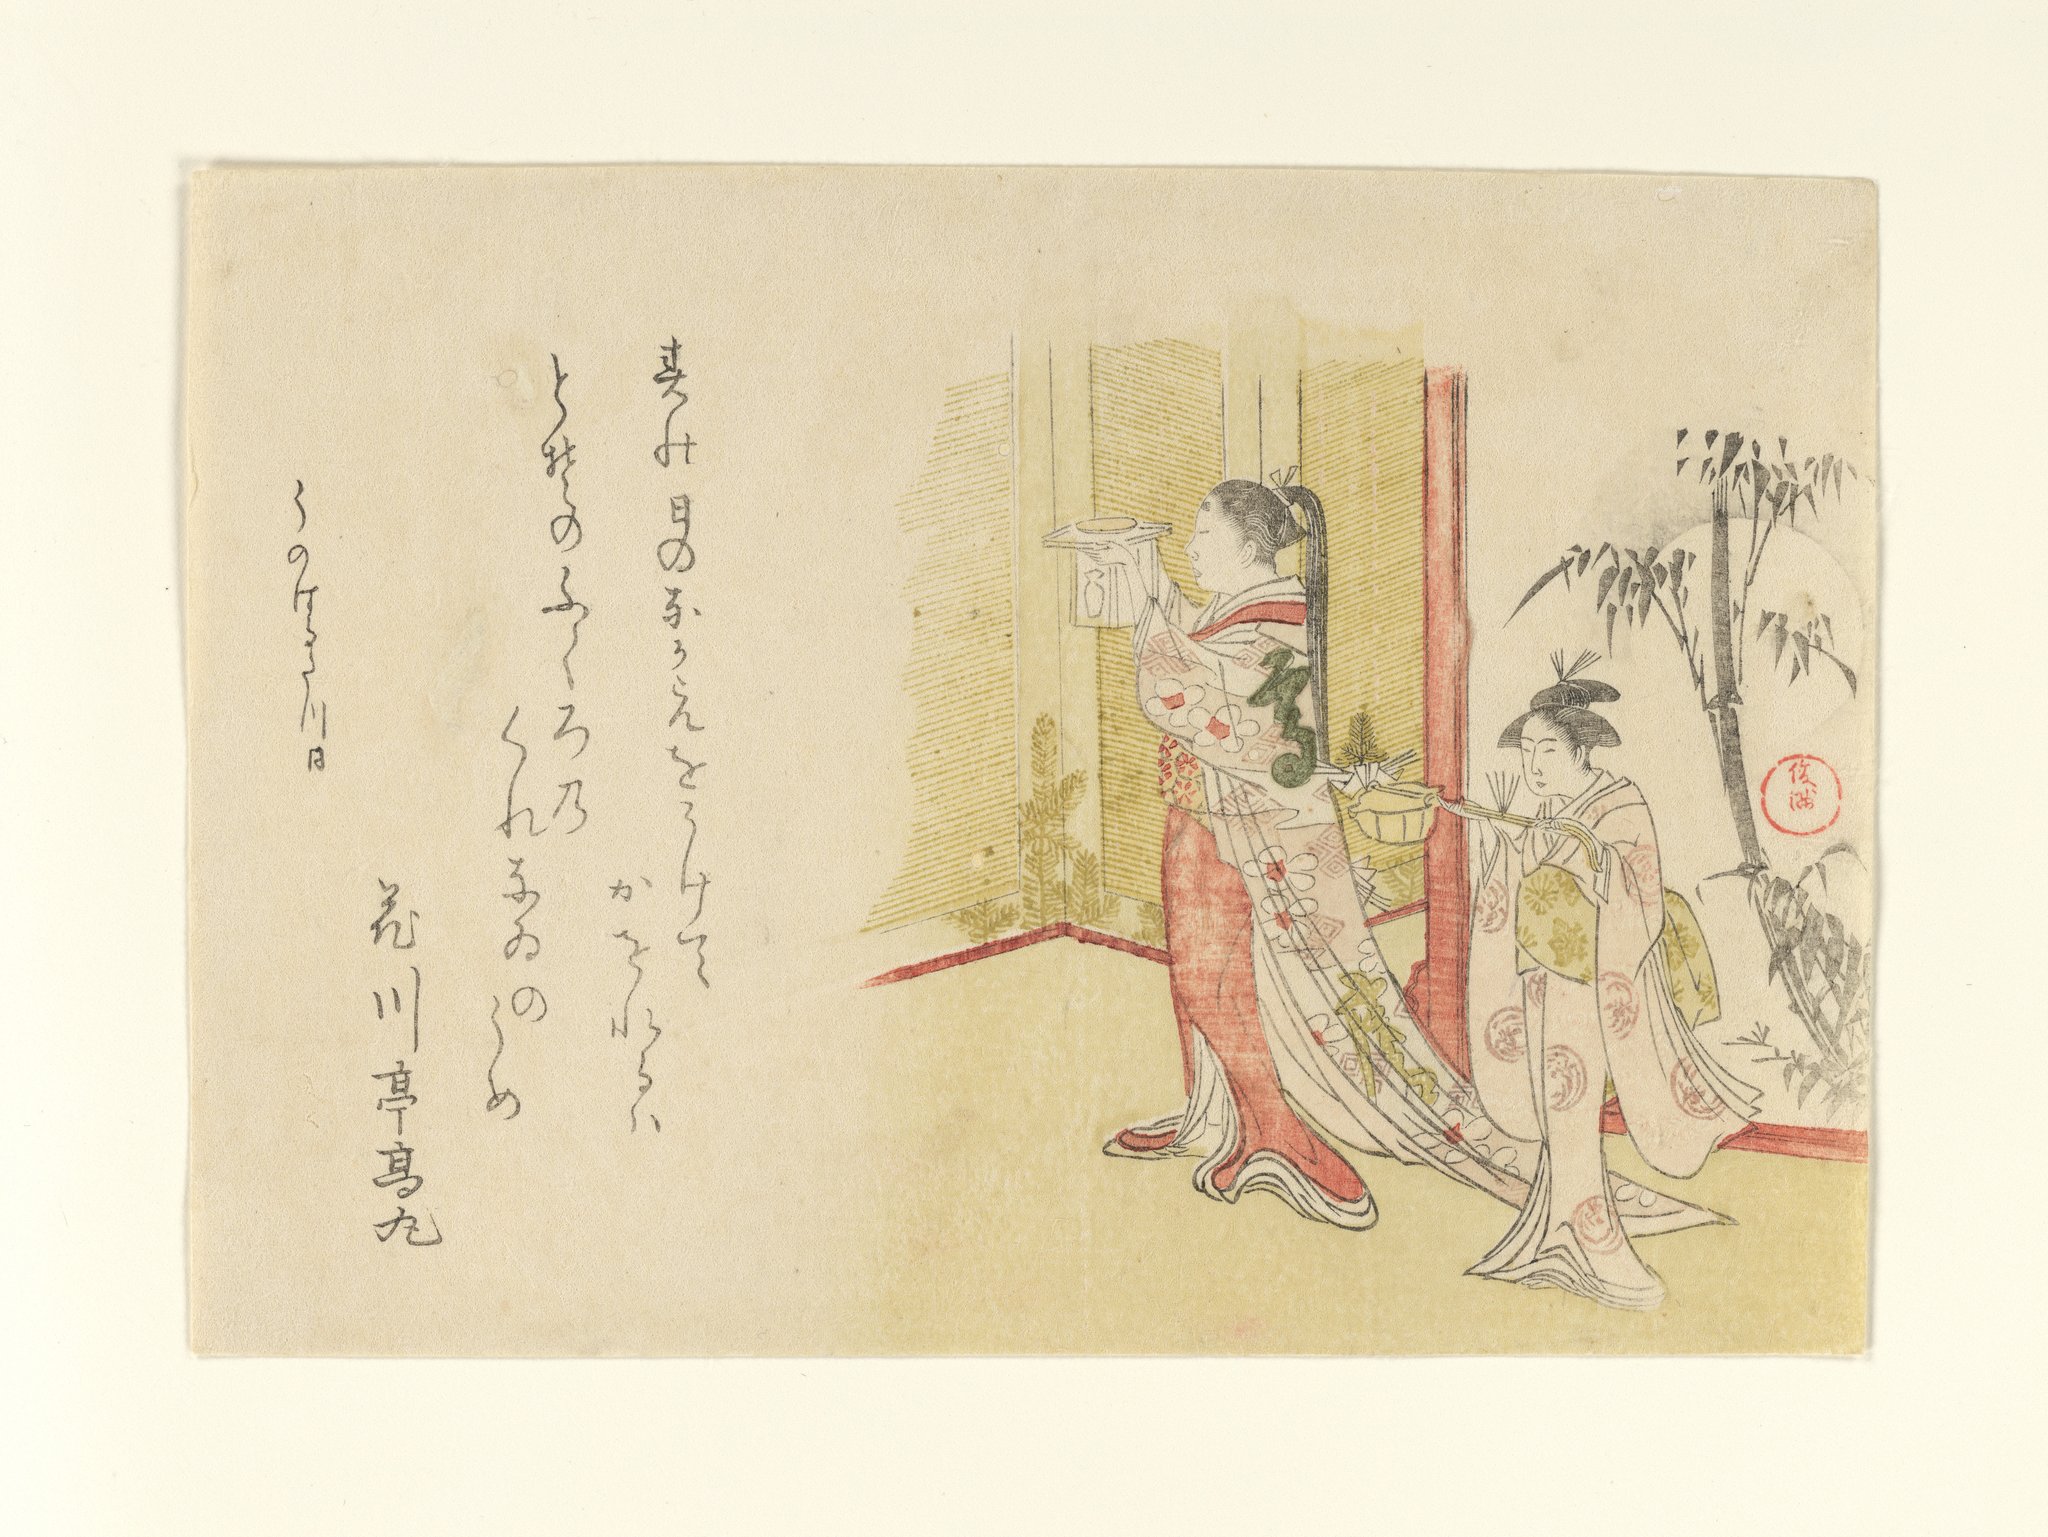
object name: print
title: Court Lady and Attendant Present New Year Wine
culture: japanese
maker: kubo shunman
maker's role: artist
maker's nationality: japanese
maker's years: 1757-1820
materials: ink, paper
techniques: surimono, woodblock print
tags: women,plants